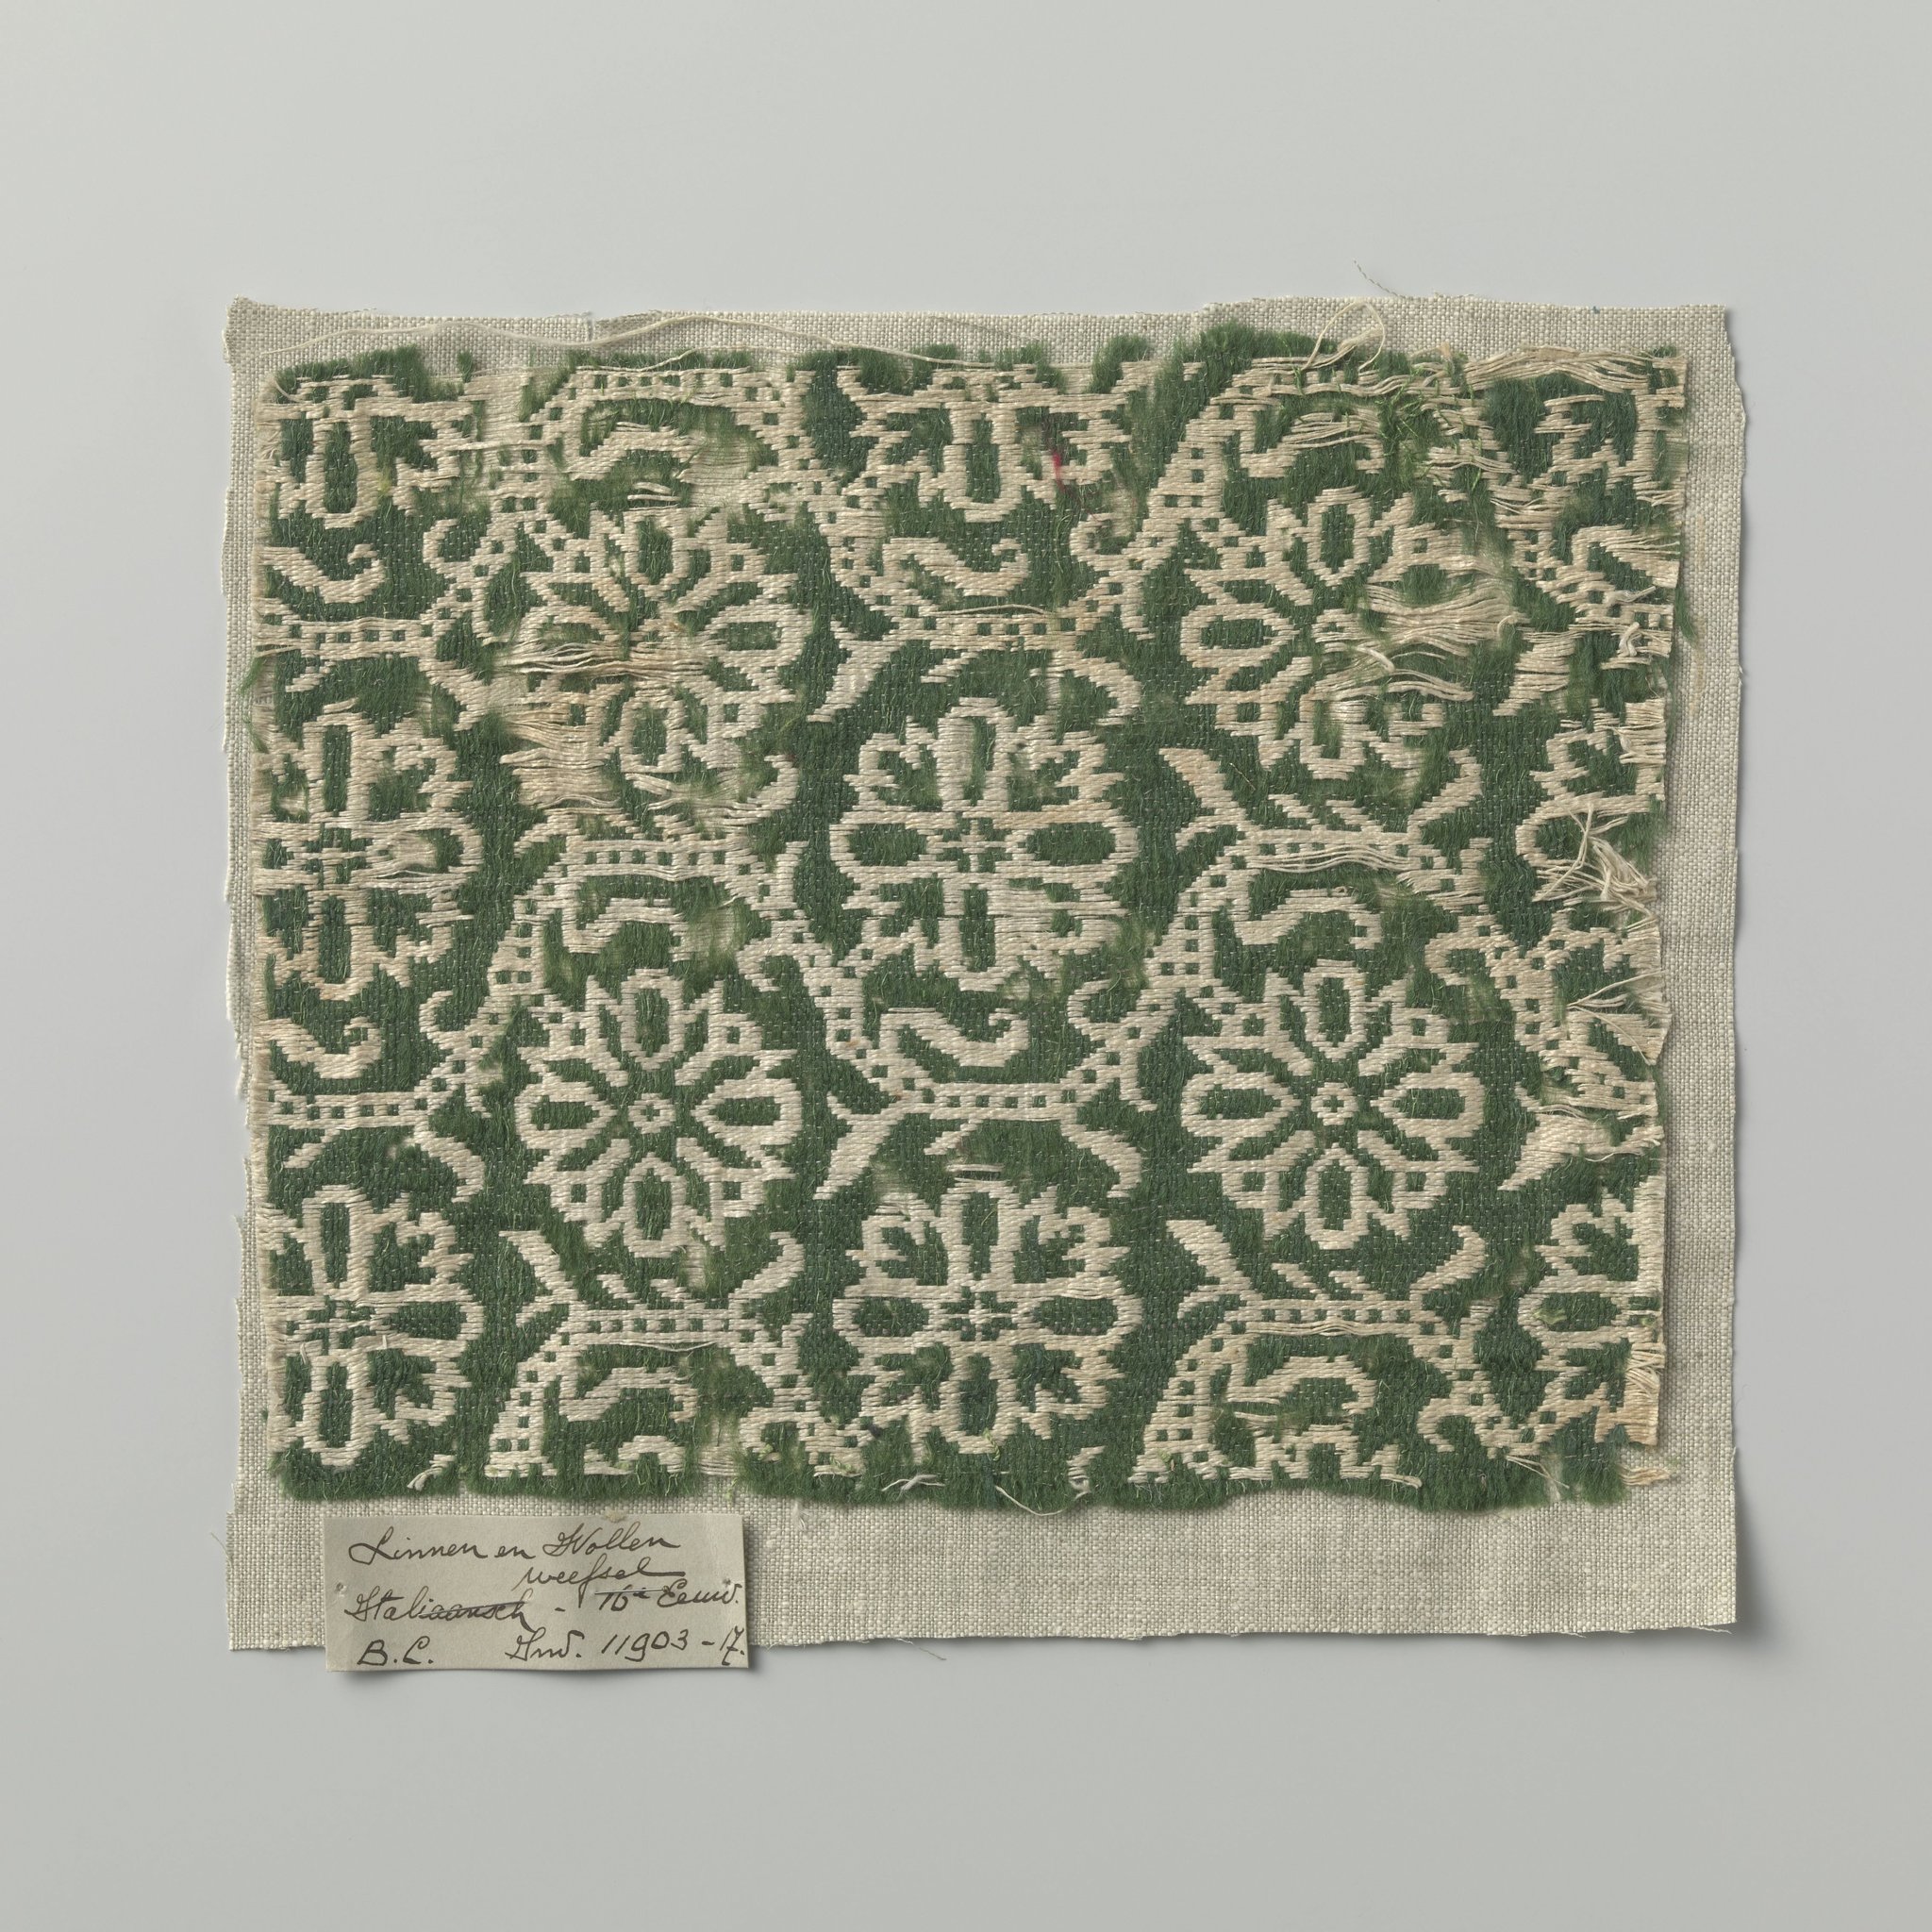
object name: woven material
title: Fragment gefigureerd weefsel in linnen en wol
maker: Anonymous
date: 1500-1599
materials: linen, wool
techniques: weave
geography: italy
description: Fragment met op donkergroen fond in wit een patroon van rozetten, afgewisseld met slingerend bandwerk.